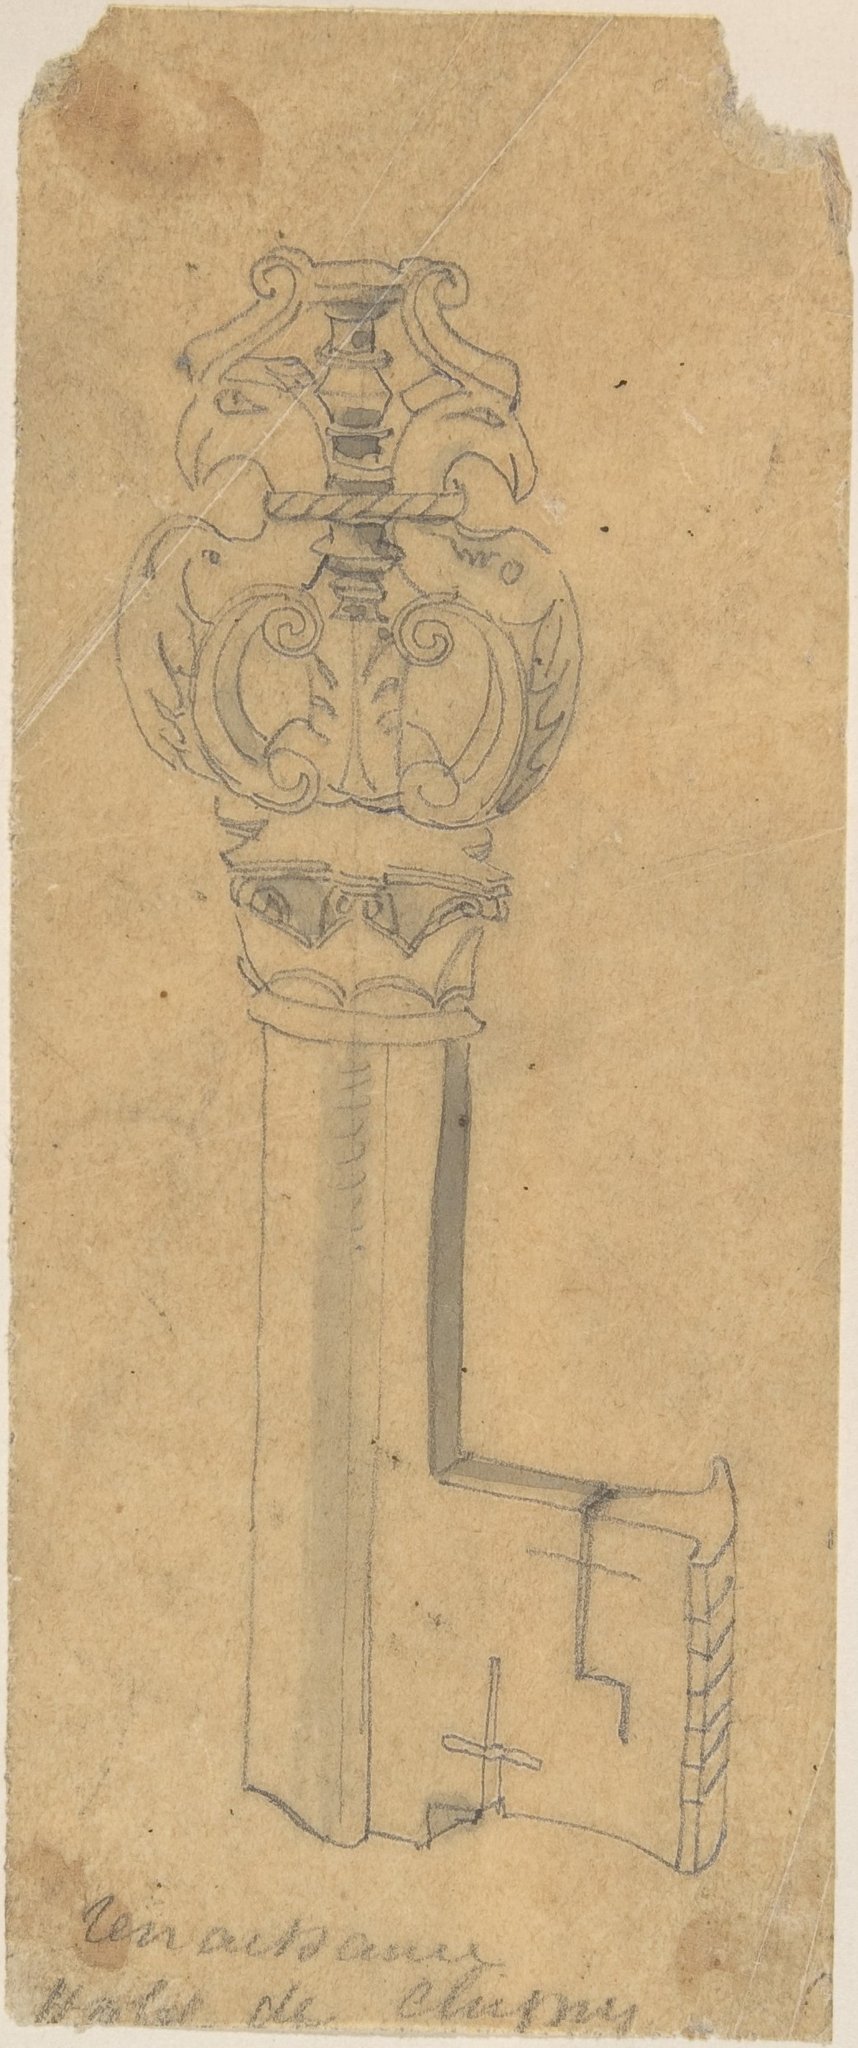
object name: drawing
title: Key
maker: anonymous, british, 19th century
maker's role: artist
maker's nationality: british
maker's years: 1800-1900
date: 1851-1900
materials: graphite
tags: keys